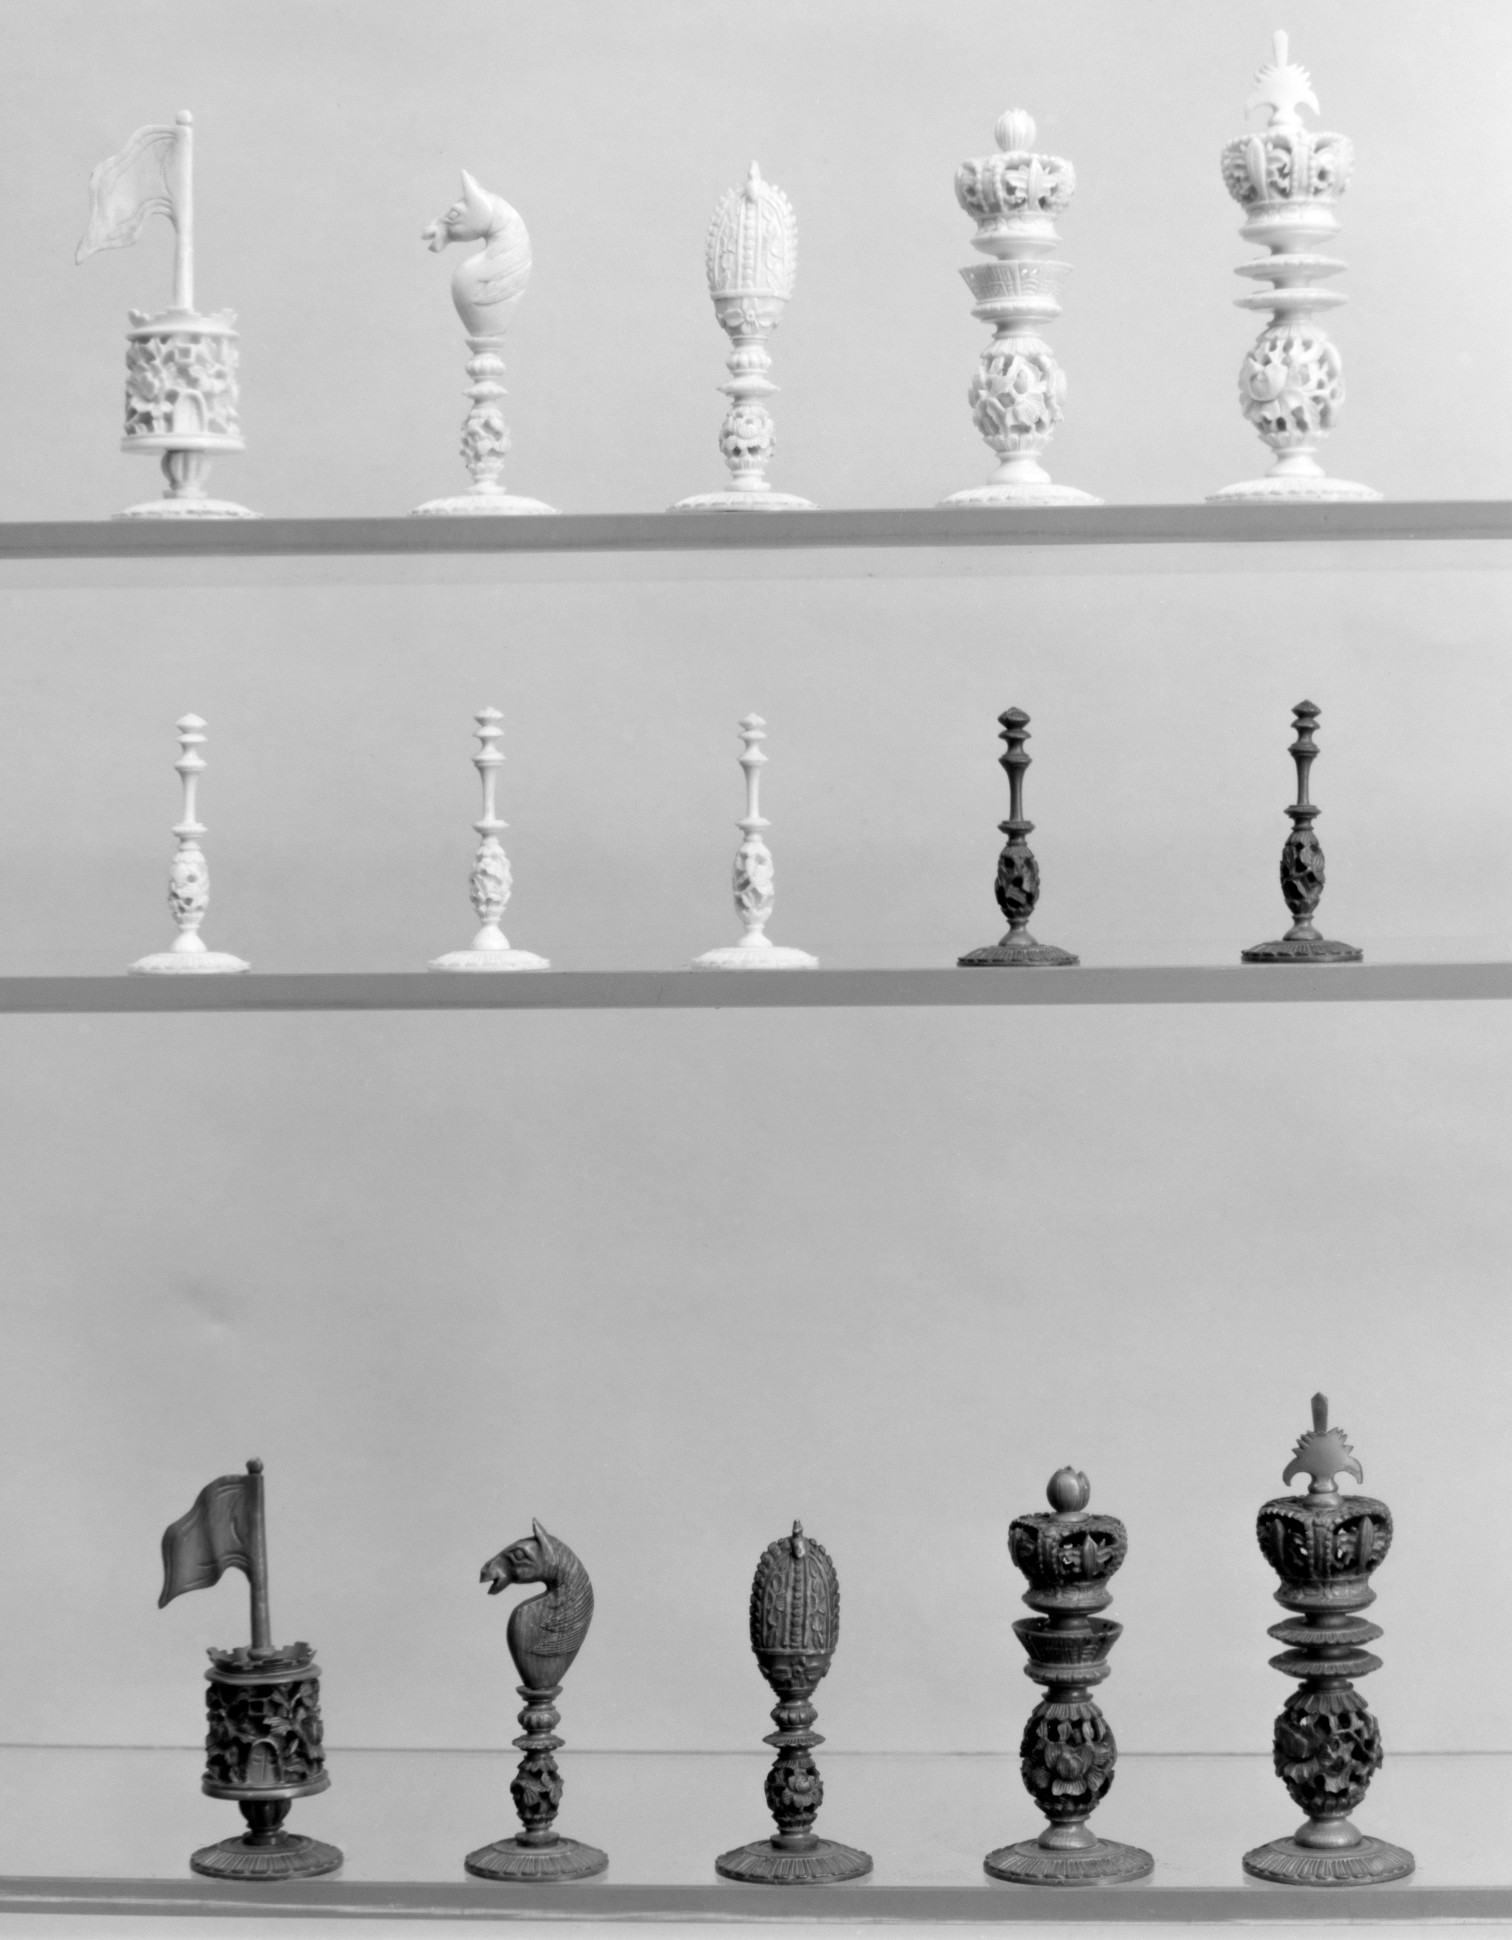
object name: chessman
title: Chessmen (32)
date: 1801-1900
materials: ivory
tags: chess,games